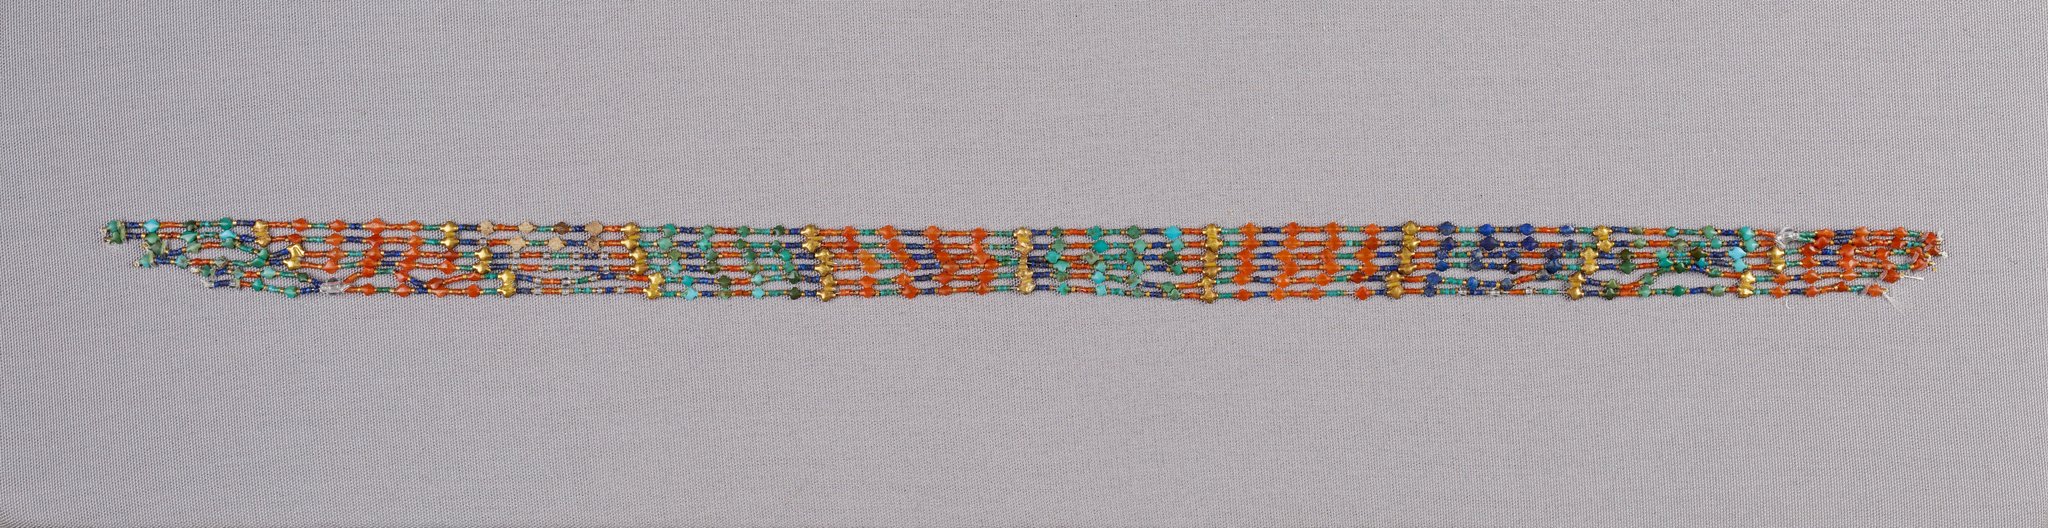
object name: girdle, bead, senebtisi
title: Acacia Bead Girdle of Senebtisi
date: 1859-1770 BCE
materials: gemstone, crystal, gold, ivory, lapis lazuli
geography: egypt